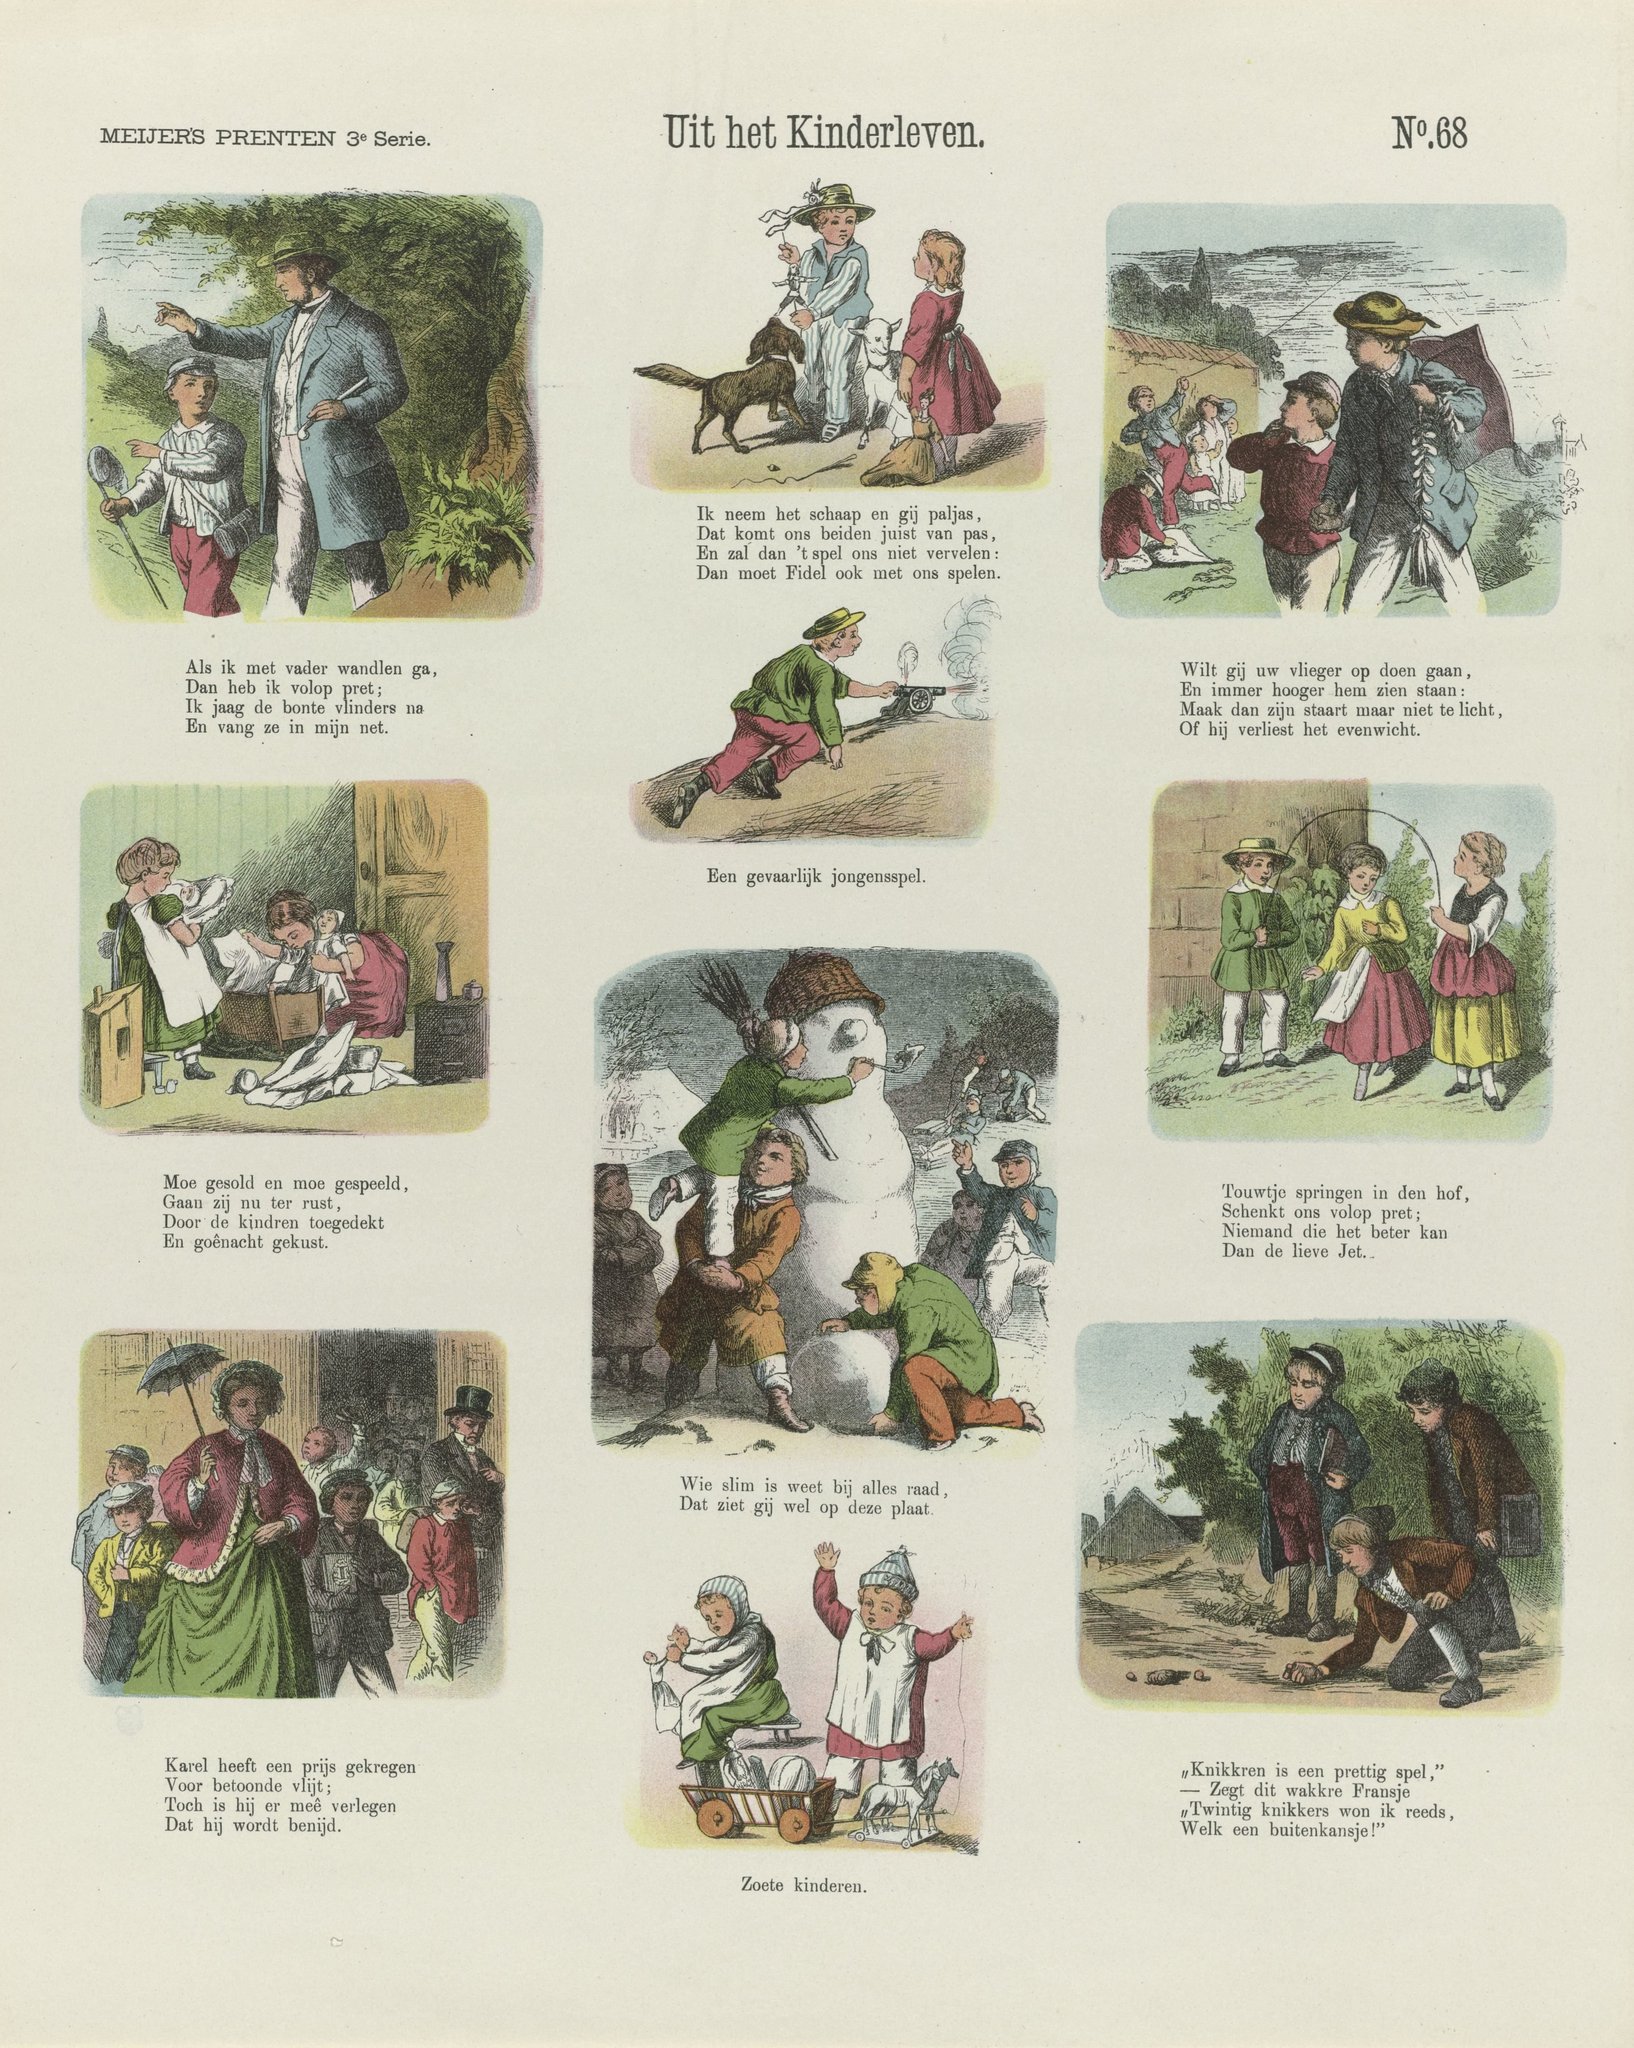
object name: popular print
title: Meijer's prenten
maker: Anonymous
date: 1878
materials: paper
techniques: lithograph, letterpress printing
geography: amsterdam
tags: children's games and plays, (playing with) dolls, (flying a) kite, jumping-rope games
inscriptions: collector's mark: Lugt 2760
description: Blad met 10 voorstellingen van kinderspelen en bezigheden, waaronder vlinders vangen, spelen met de pop en paljas, vliegeren, touwtjespringen en spelen met paard, kar en poppen. Onder elke voorstelling een onderschrift. Genummerd rechtsboven: No. 68.